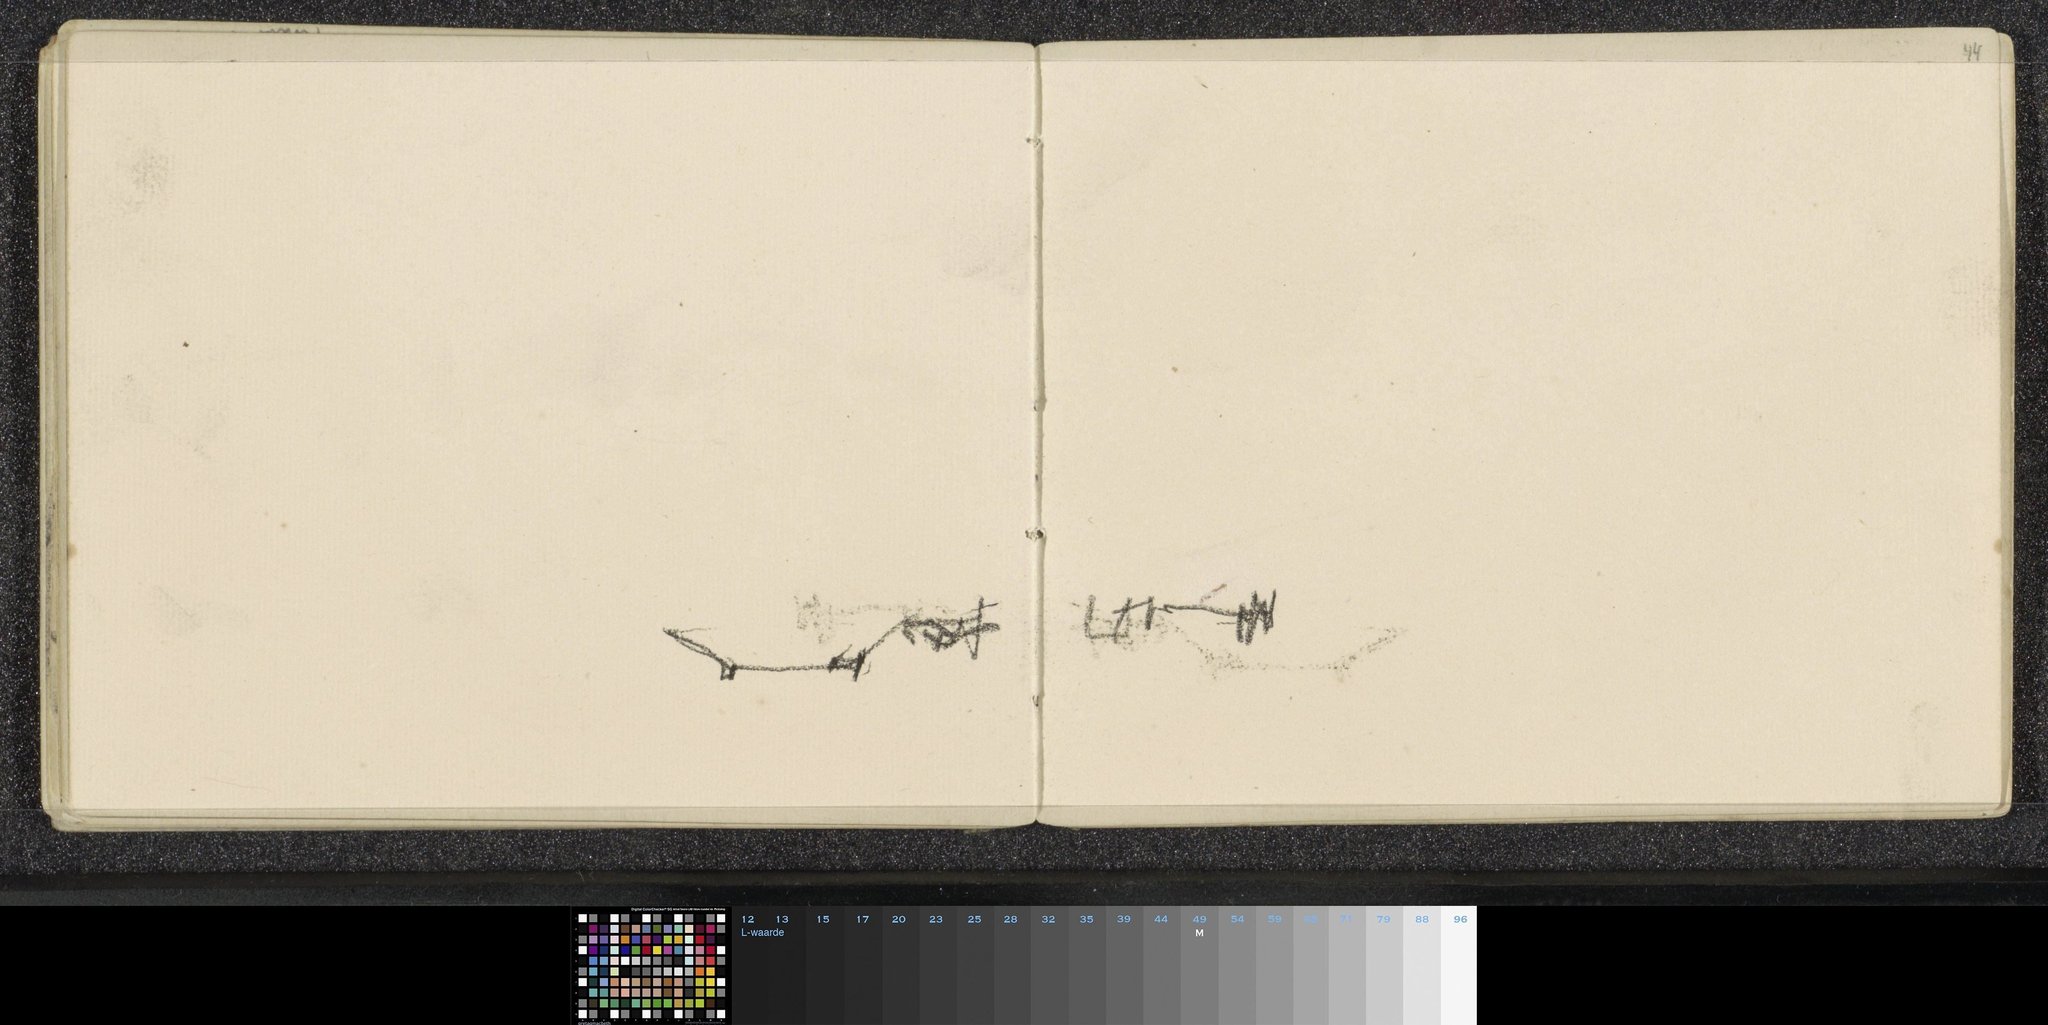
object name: sketchbook leaf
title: Studie, mogelijk van daken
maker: george hendrik breitner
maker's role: draughtsman, painter, print maker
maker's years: 1857-1923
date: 1893-1899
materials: chalk, paper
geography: amsterdam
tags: roof (of house or building)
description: Pagina 43 en pagina 44 uit een schetsboek met 28 bladen.